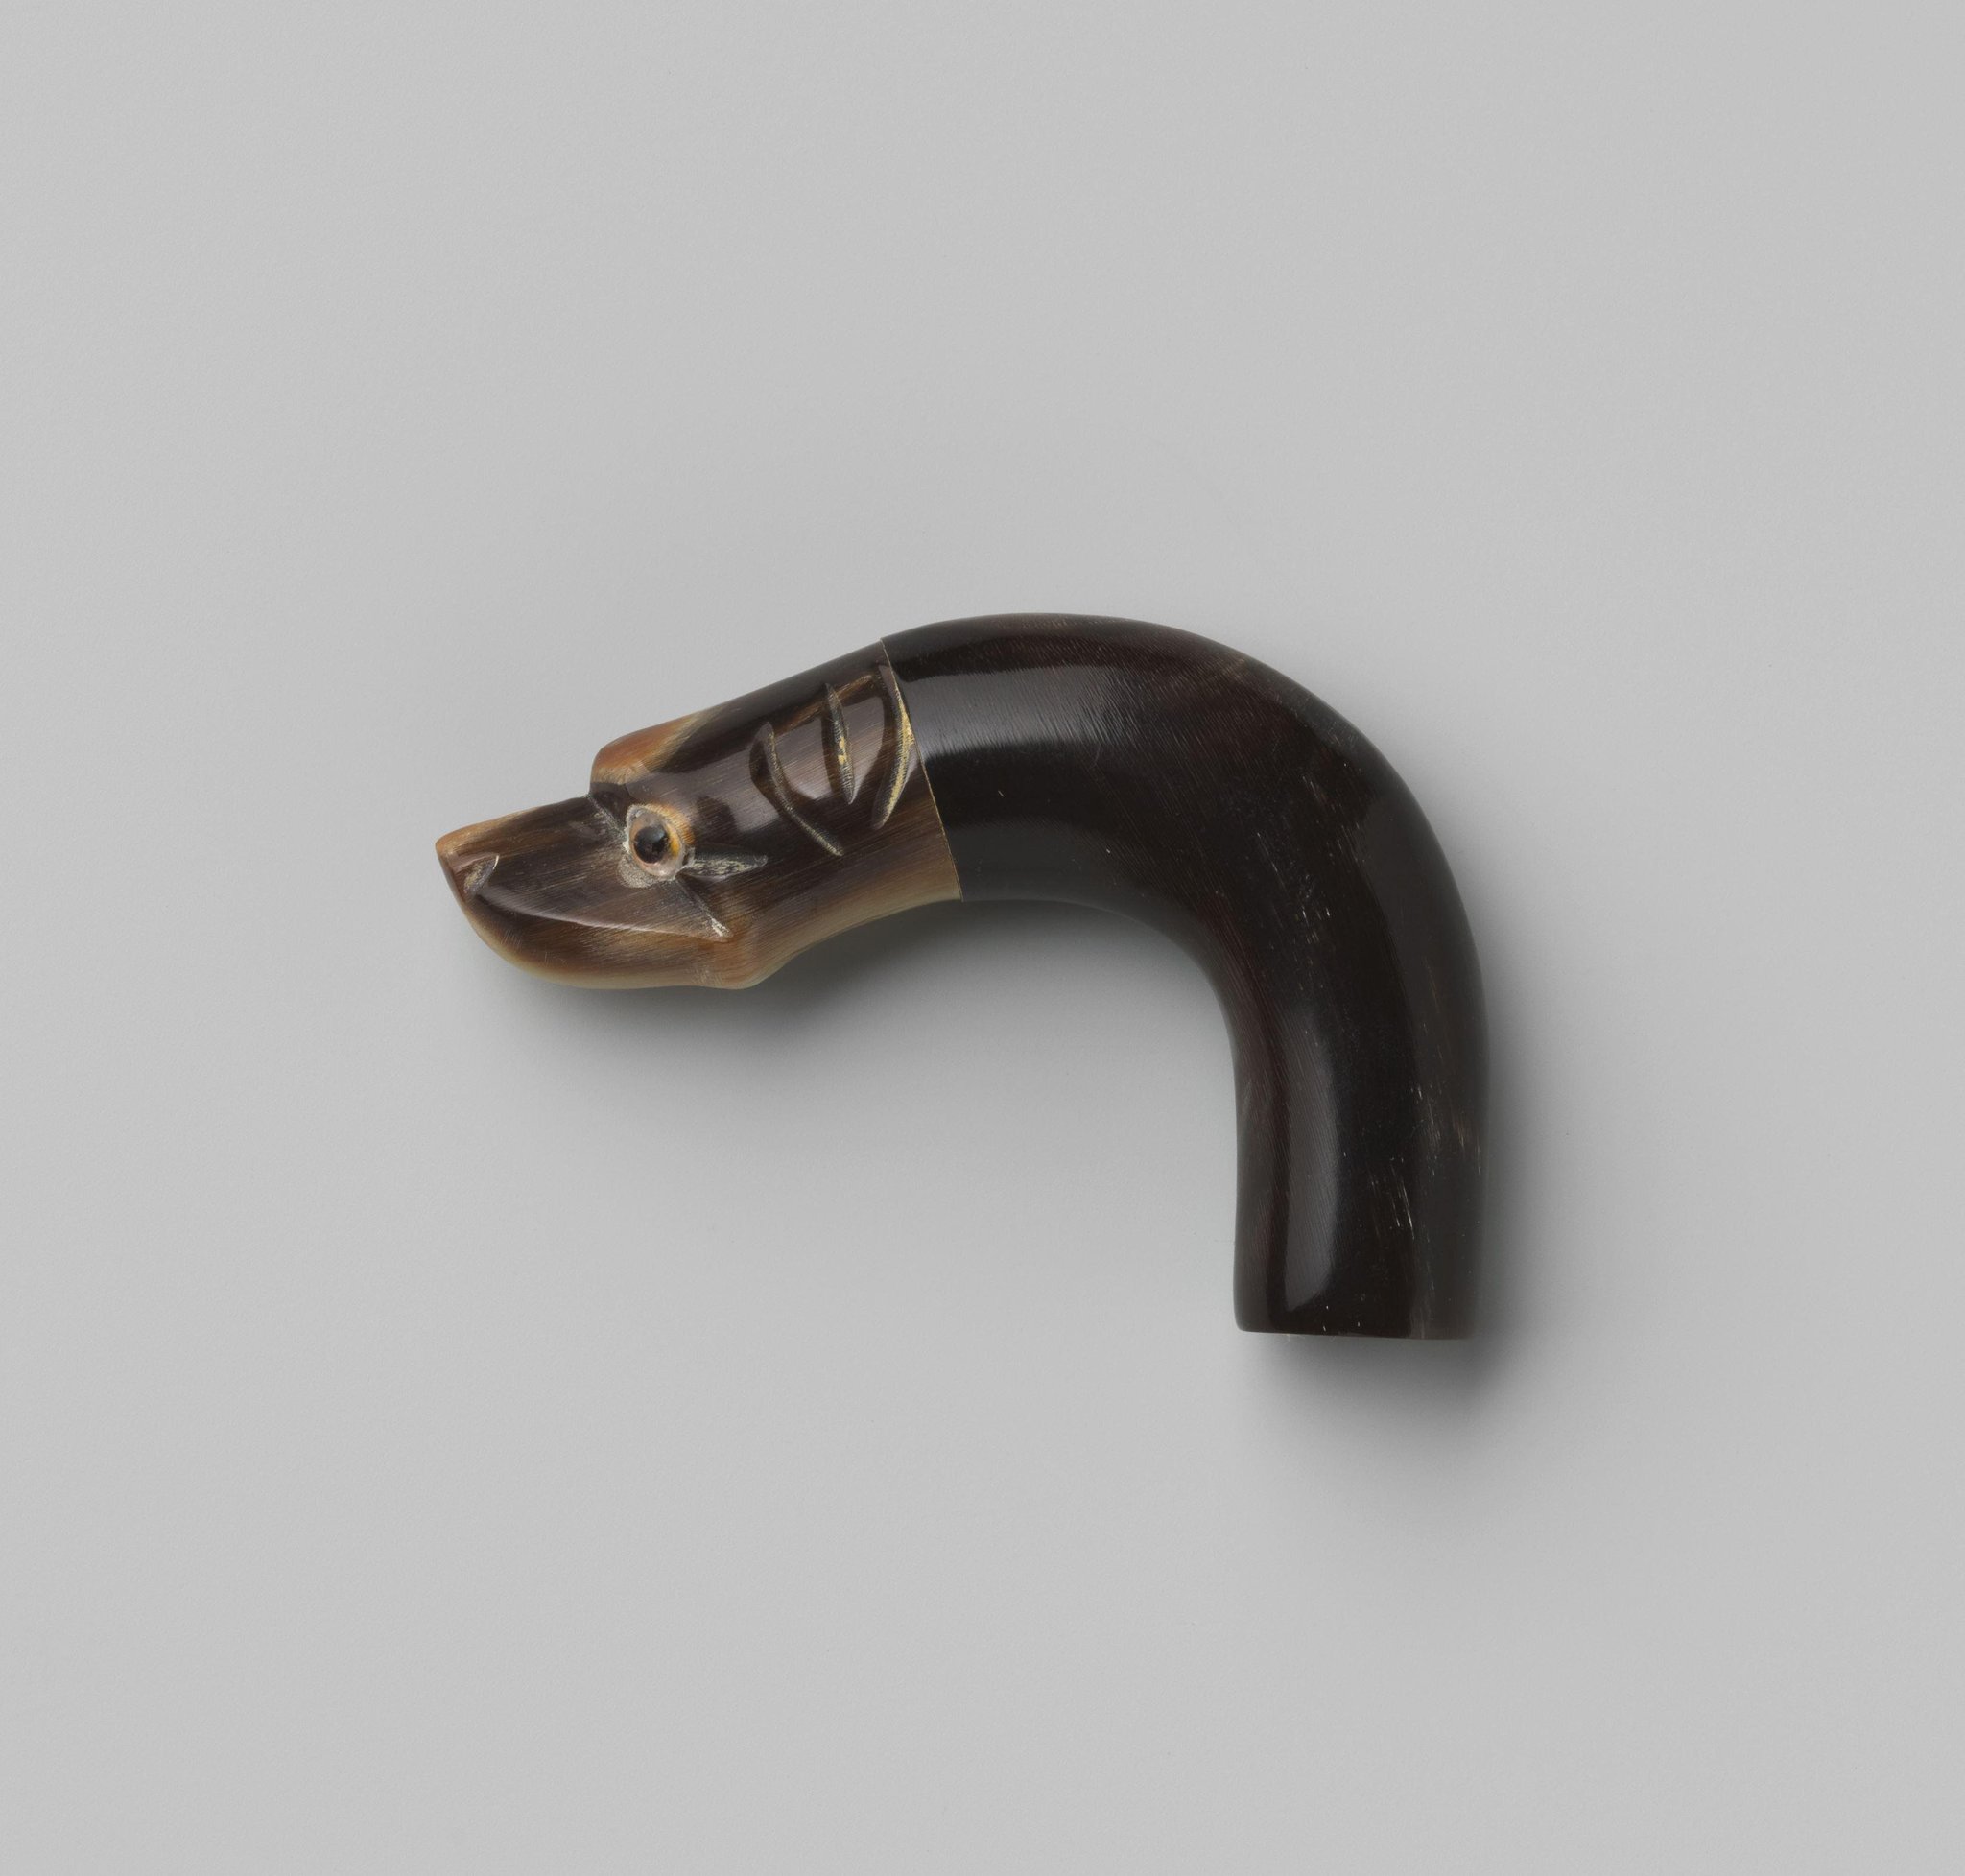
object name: haakknop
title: Knop van zwart hoorn, eindigend in een hondenkop van beige-bruin hoorn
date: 1900-1930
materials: glass, horn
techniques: manufacturing, cutting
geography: netherlands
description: Knop van zwart hoorn, eindigend in een hondenkop van beige-bruin hoorn, ogen van glas.